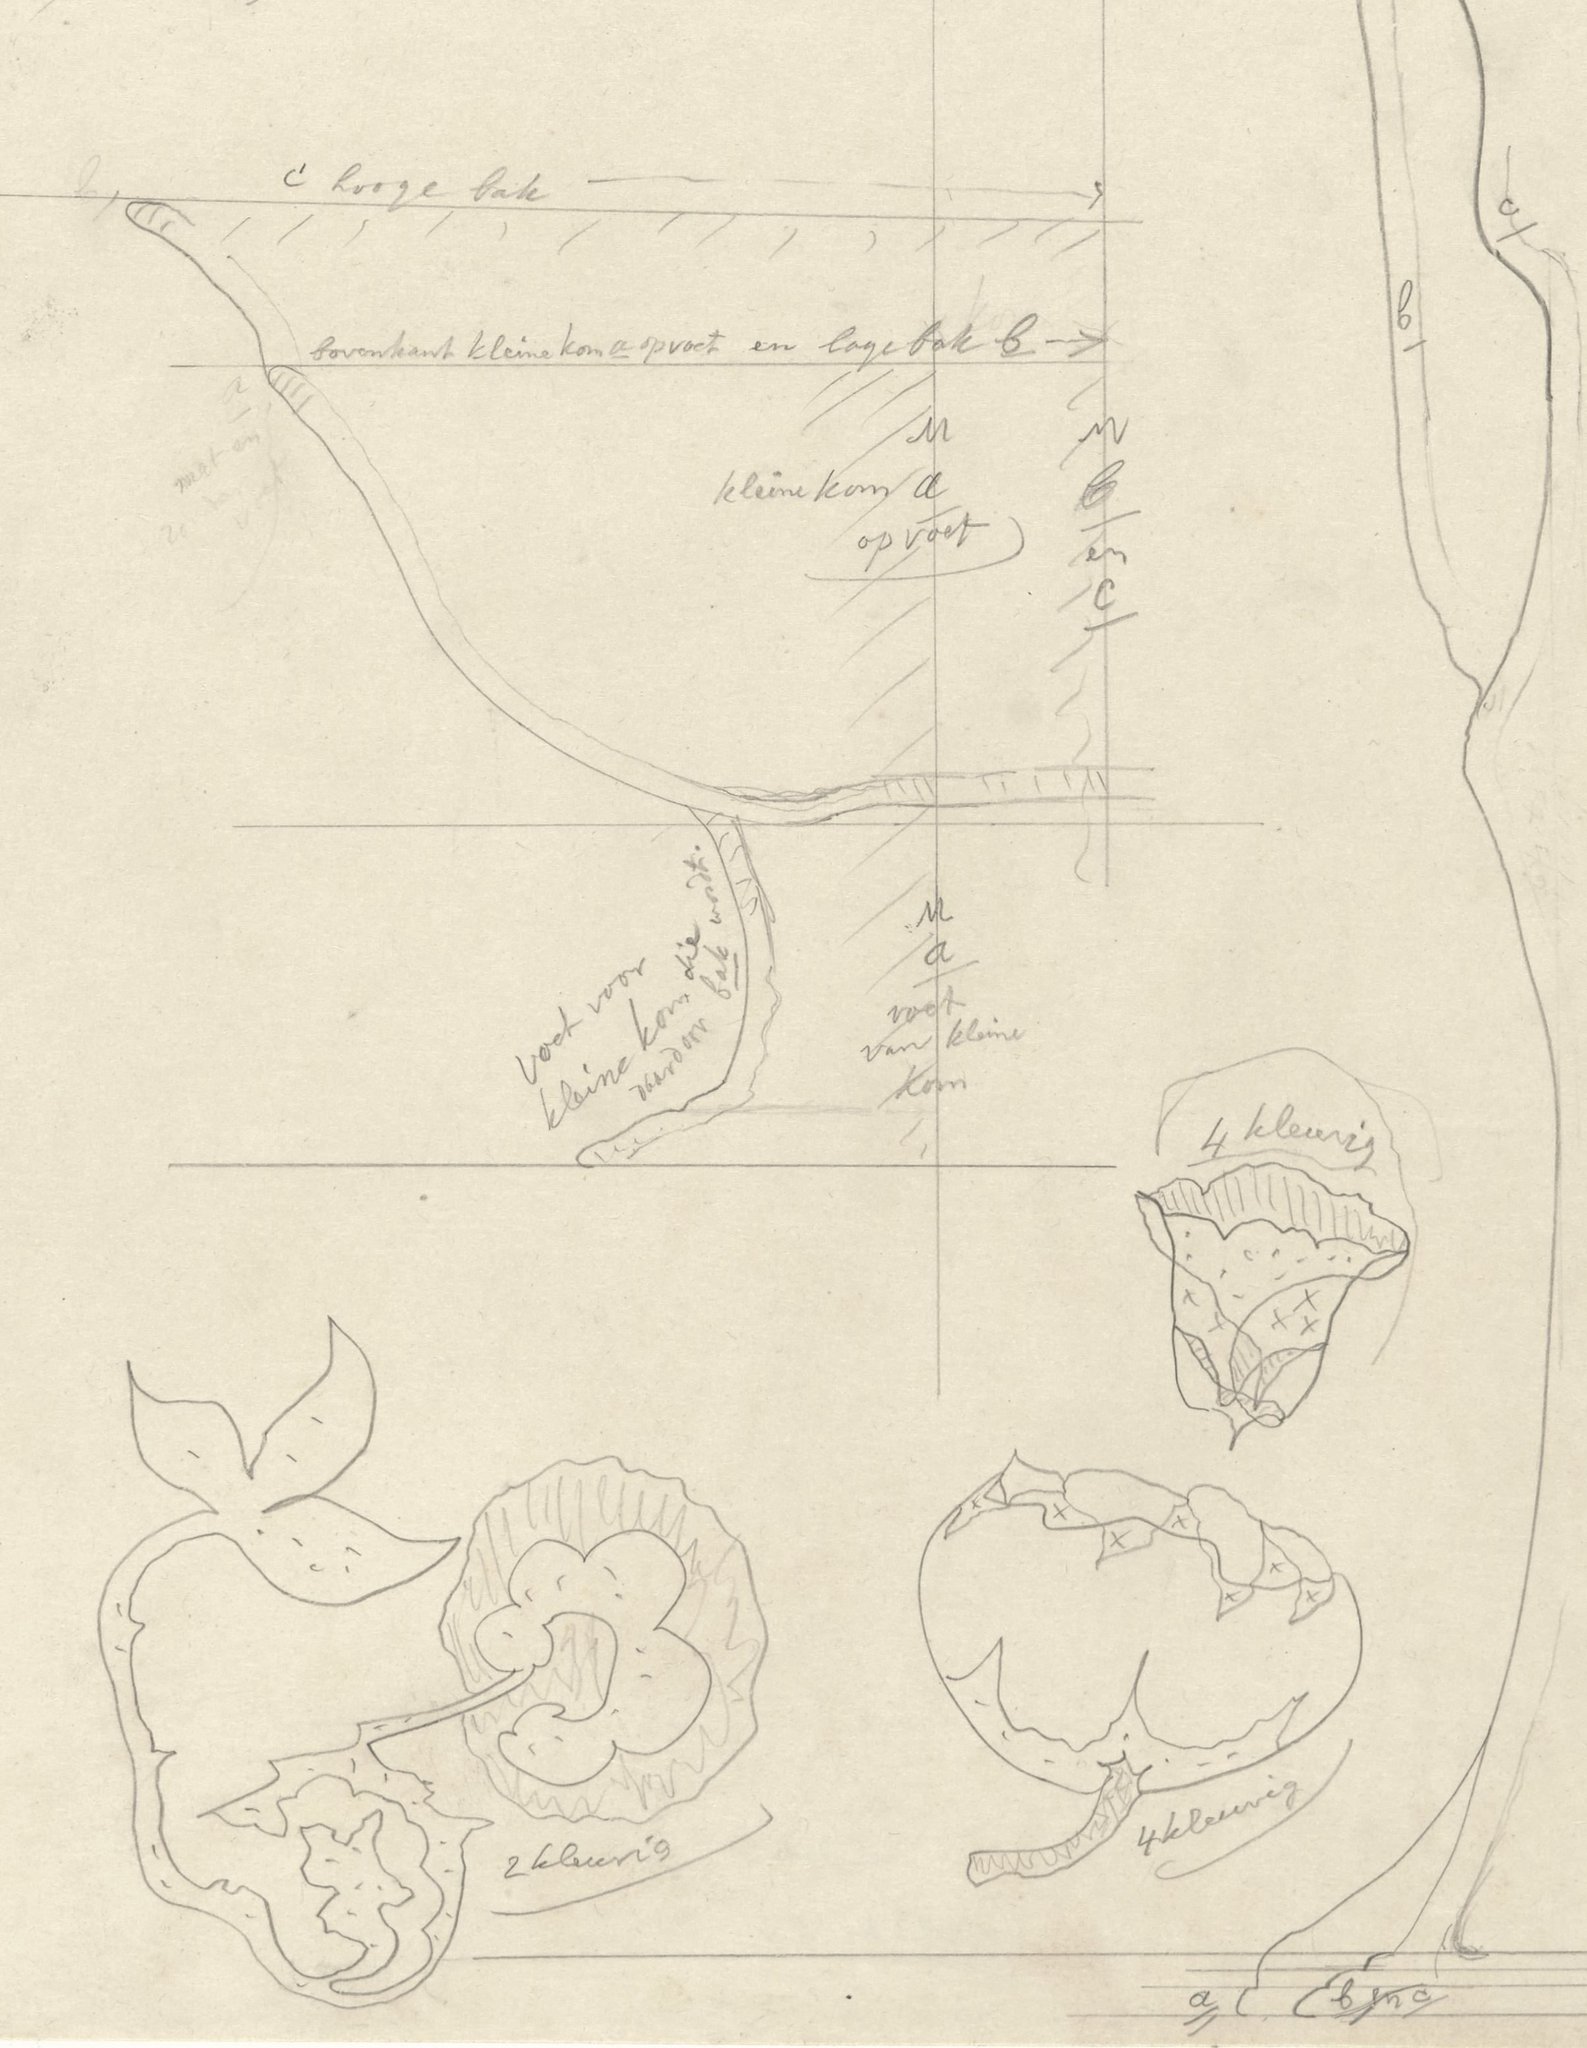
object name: drawing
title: Zes ontwerpen Iseger in halfprofiel voor vazen en kommen en drie bloemmotieven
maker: theo colenbrander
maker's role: draughtsman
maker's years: 1841-1930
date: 1920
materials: paper, pencil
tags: bowl, container of ceramics: jar, jug, pot, vase, flowers ~ ornament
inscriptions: date: ‘18 Juni 20’